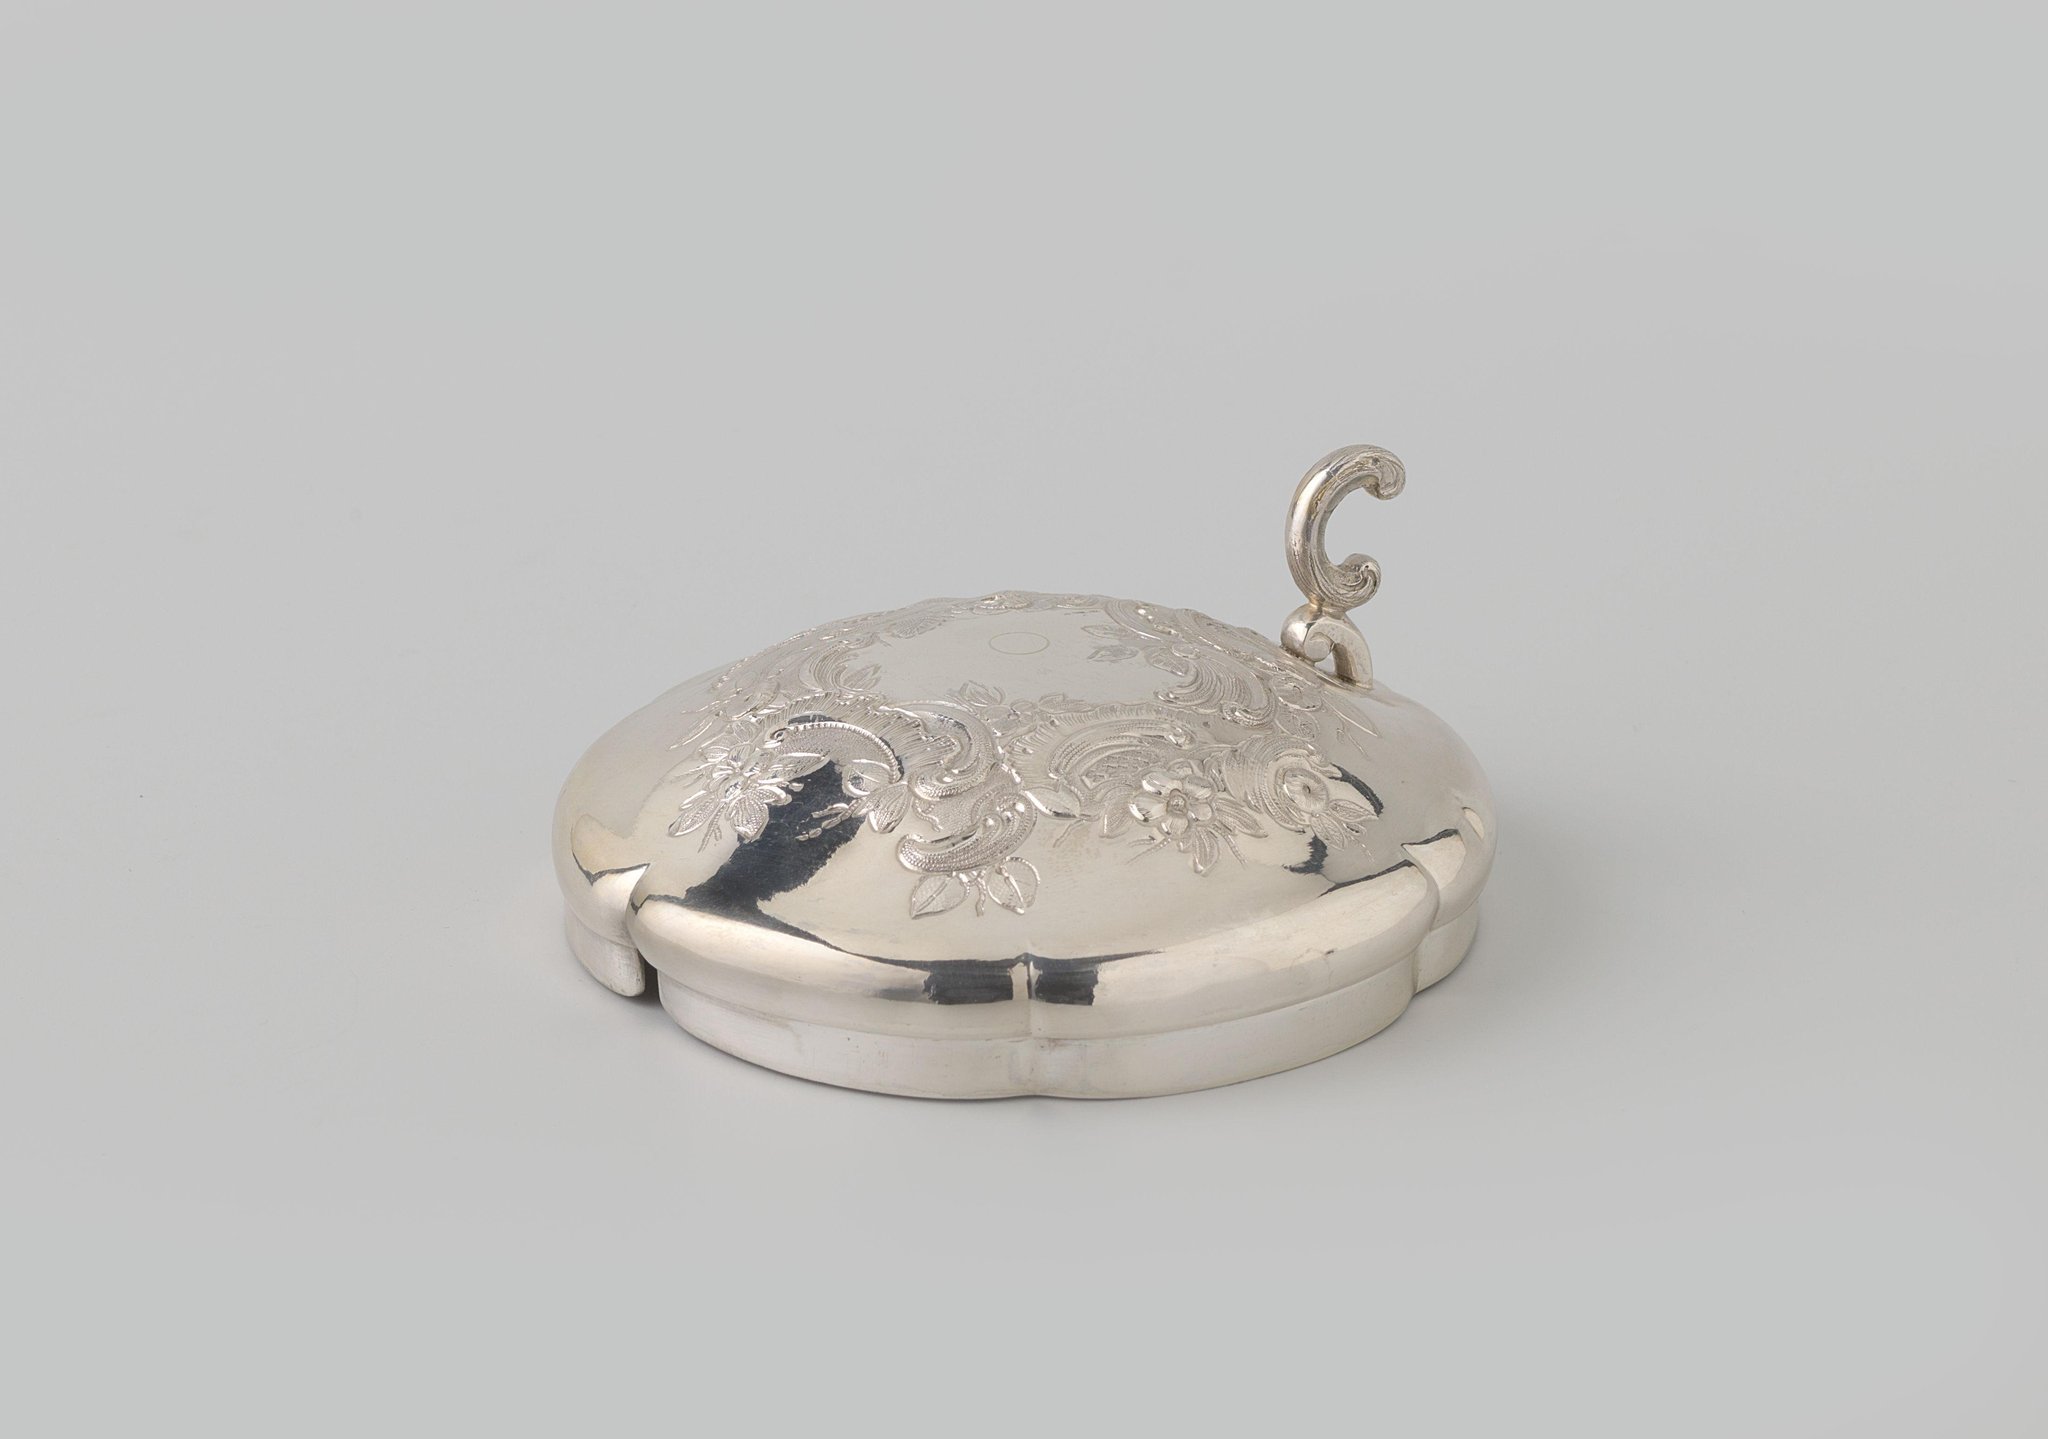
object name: lid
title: Zilveren deksel uit een koffie- en theeservies van elf delen dat toebehoorde aan J.D. Preuijt (1801-1887), aan hem geven bij zijn jubileum in 1873.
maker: pieter zöllner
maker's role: silversmith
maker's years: 1806-1894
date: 1873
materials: silver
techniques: engraving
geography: rotterdam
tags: geervliet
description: Zilveren rond deksel dat is versierd met gegraveerde en geschulpte bloemenmotieven. Op het deksel zit een bedienhaak.